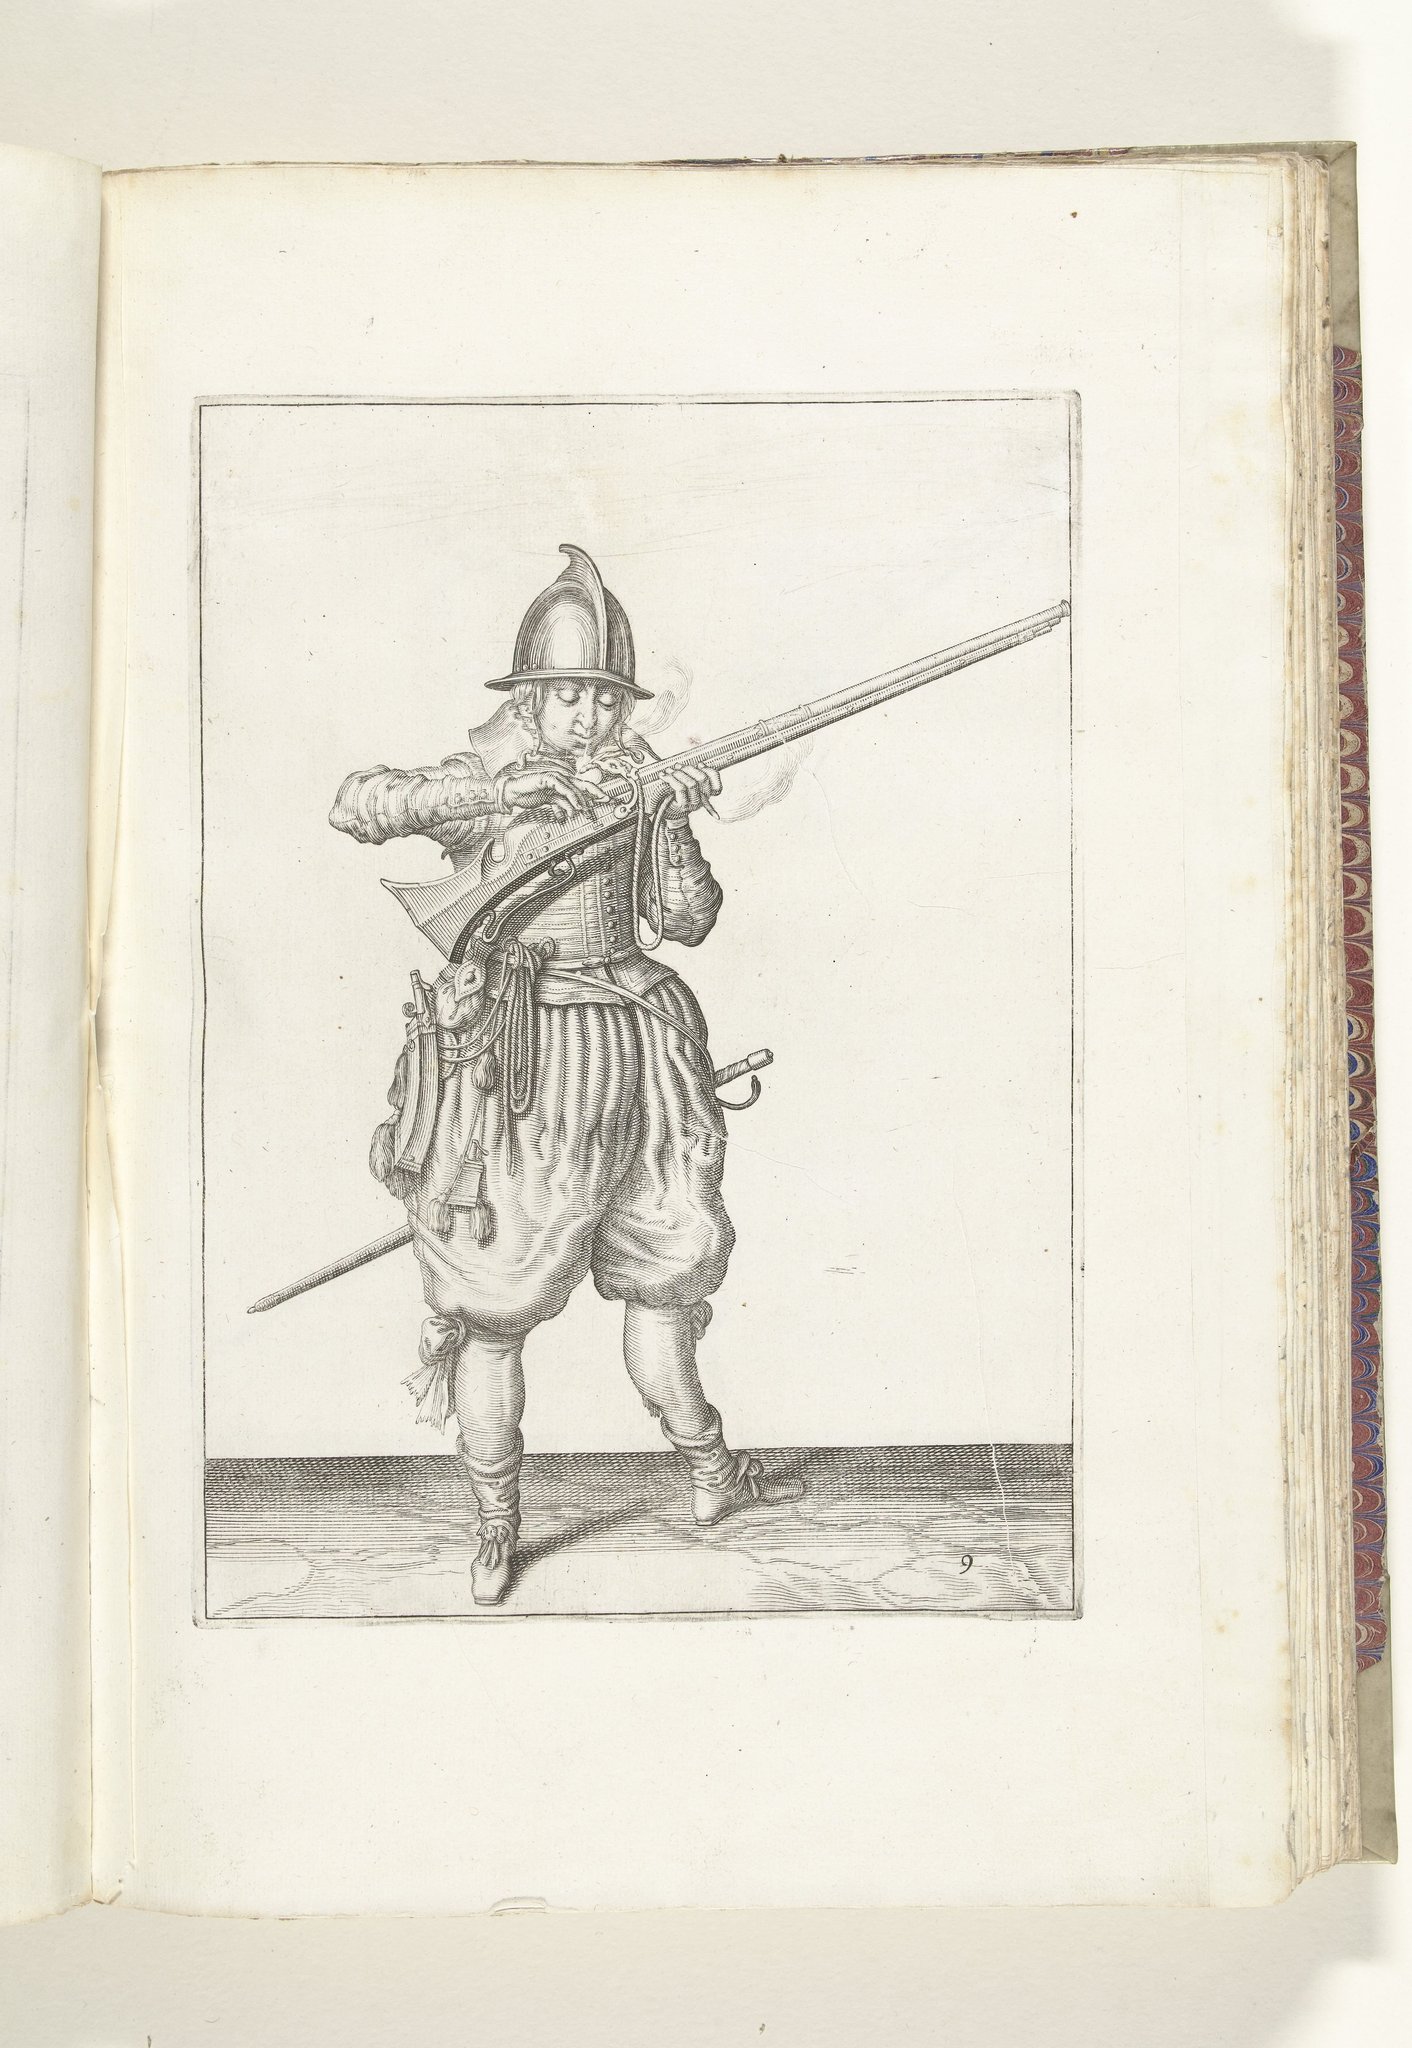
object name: print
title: Soldaat die de lont aanblaast en met zijn vingers de pan afdekt (nr. 9), ca. 1600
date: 1597-1607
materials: paper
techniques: engraving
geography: northern netherlands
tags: the hague, maurice (prince of orange), handling of weapons ~ military training, weapons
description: Een soldaat, ten voeten uit, naar rechts, die een roer (een bepaald type vuurwapen) met zijn linkerhand vasthoudt (nr. 9), ca. 1600. Hij brengt de roer naar zijn mond om de lont aan te blazen, met twee vingers dekt hij de pan af tegen vonken. Plaat 9 in de instructies voor het hanteren van de roer. Onderdeel van de illustraties in: J. de Gheyn, Wapenhandelinghe van Roers Musquetten ende spiessen, Amsterdam, 1608. Krijgswezen rond 1600.